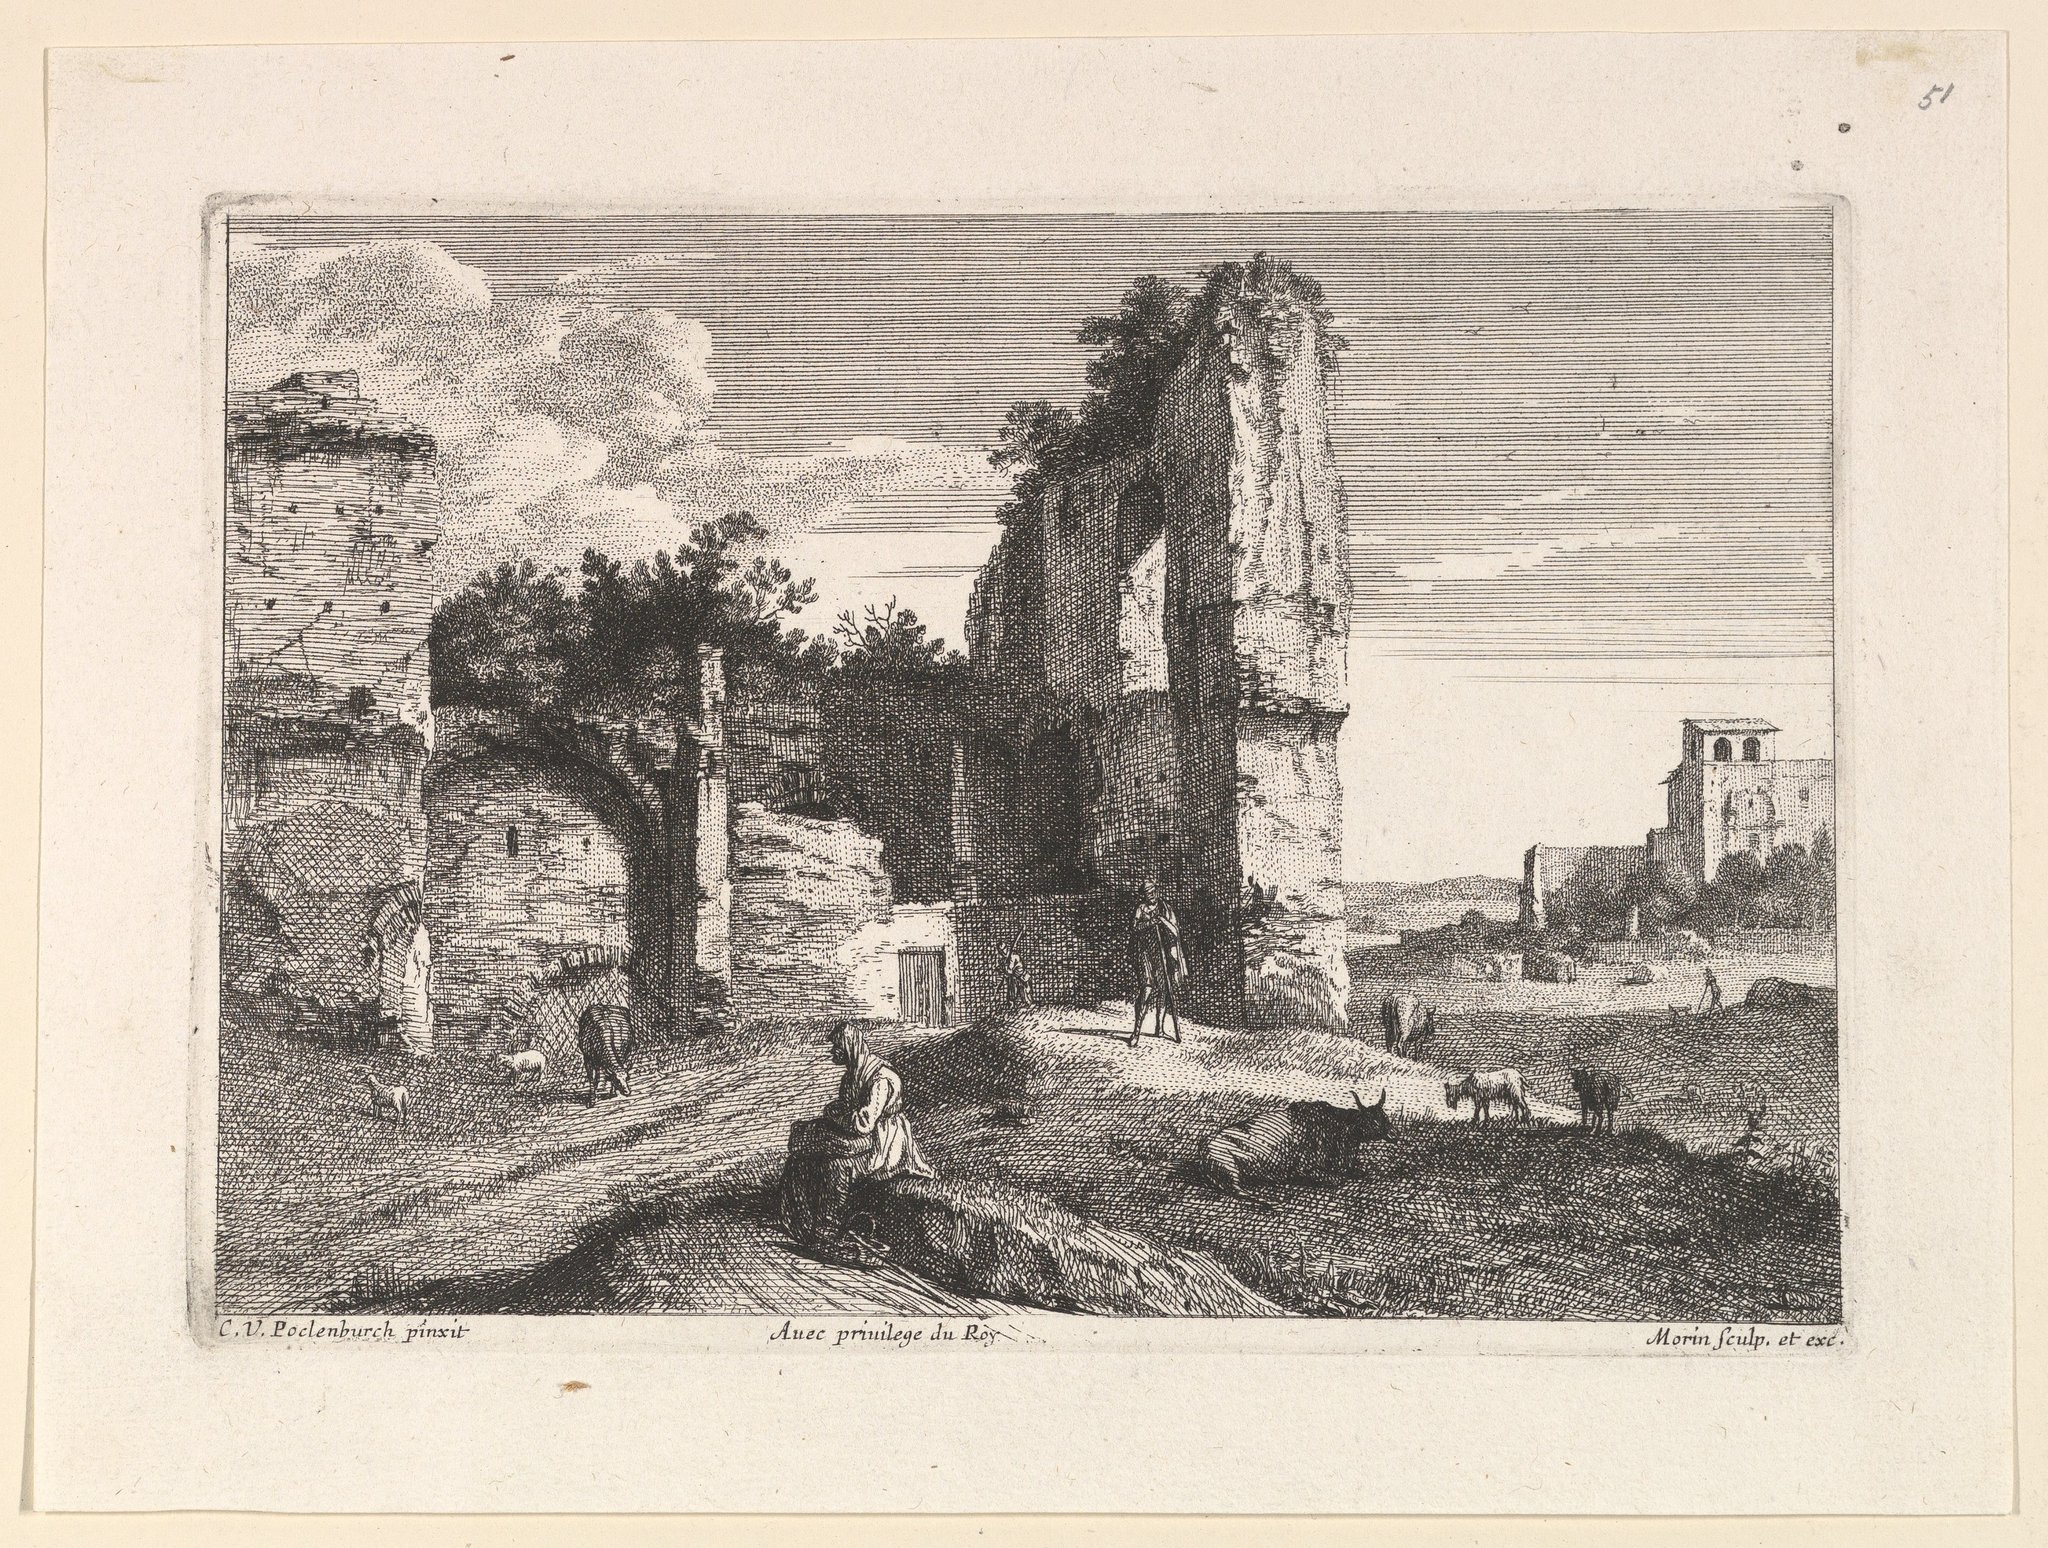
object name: print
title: La Vieille Femme Assise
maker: jean morin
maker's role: artist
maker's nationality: french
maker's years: 1605-1650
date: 1605-1650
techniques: etching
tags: human figures,animals,ruins